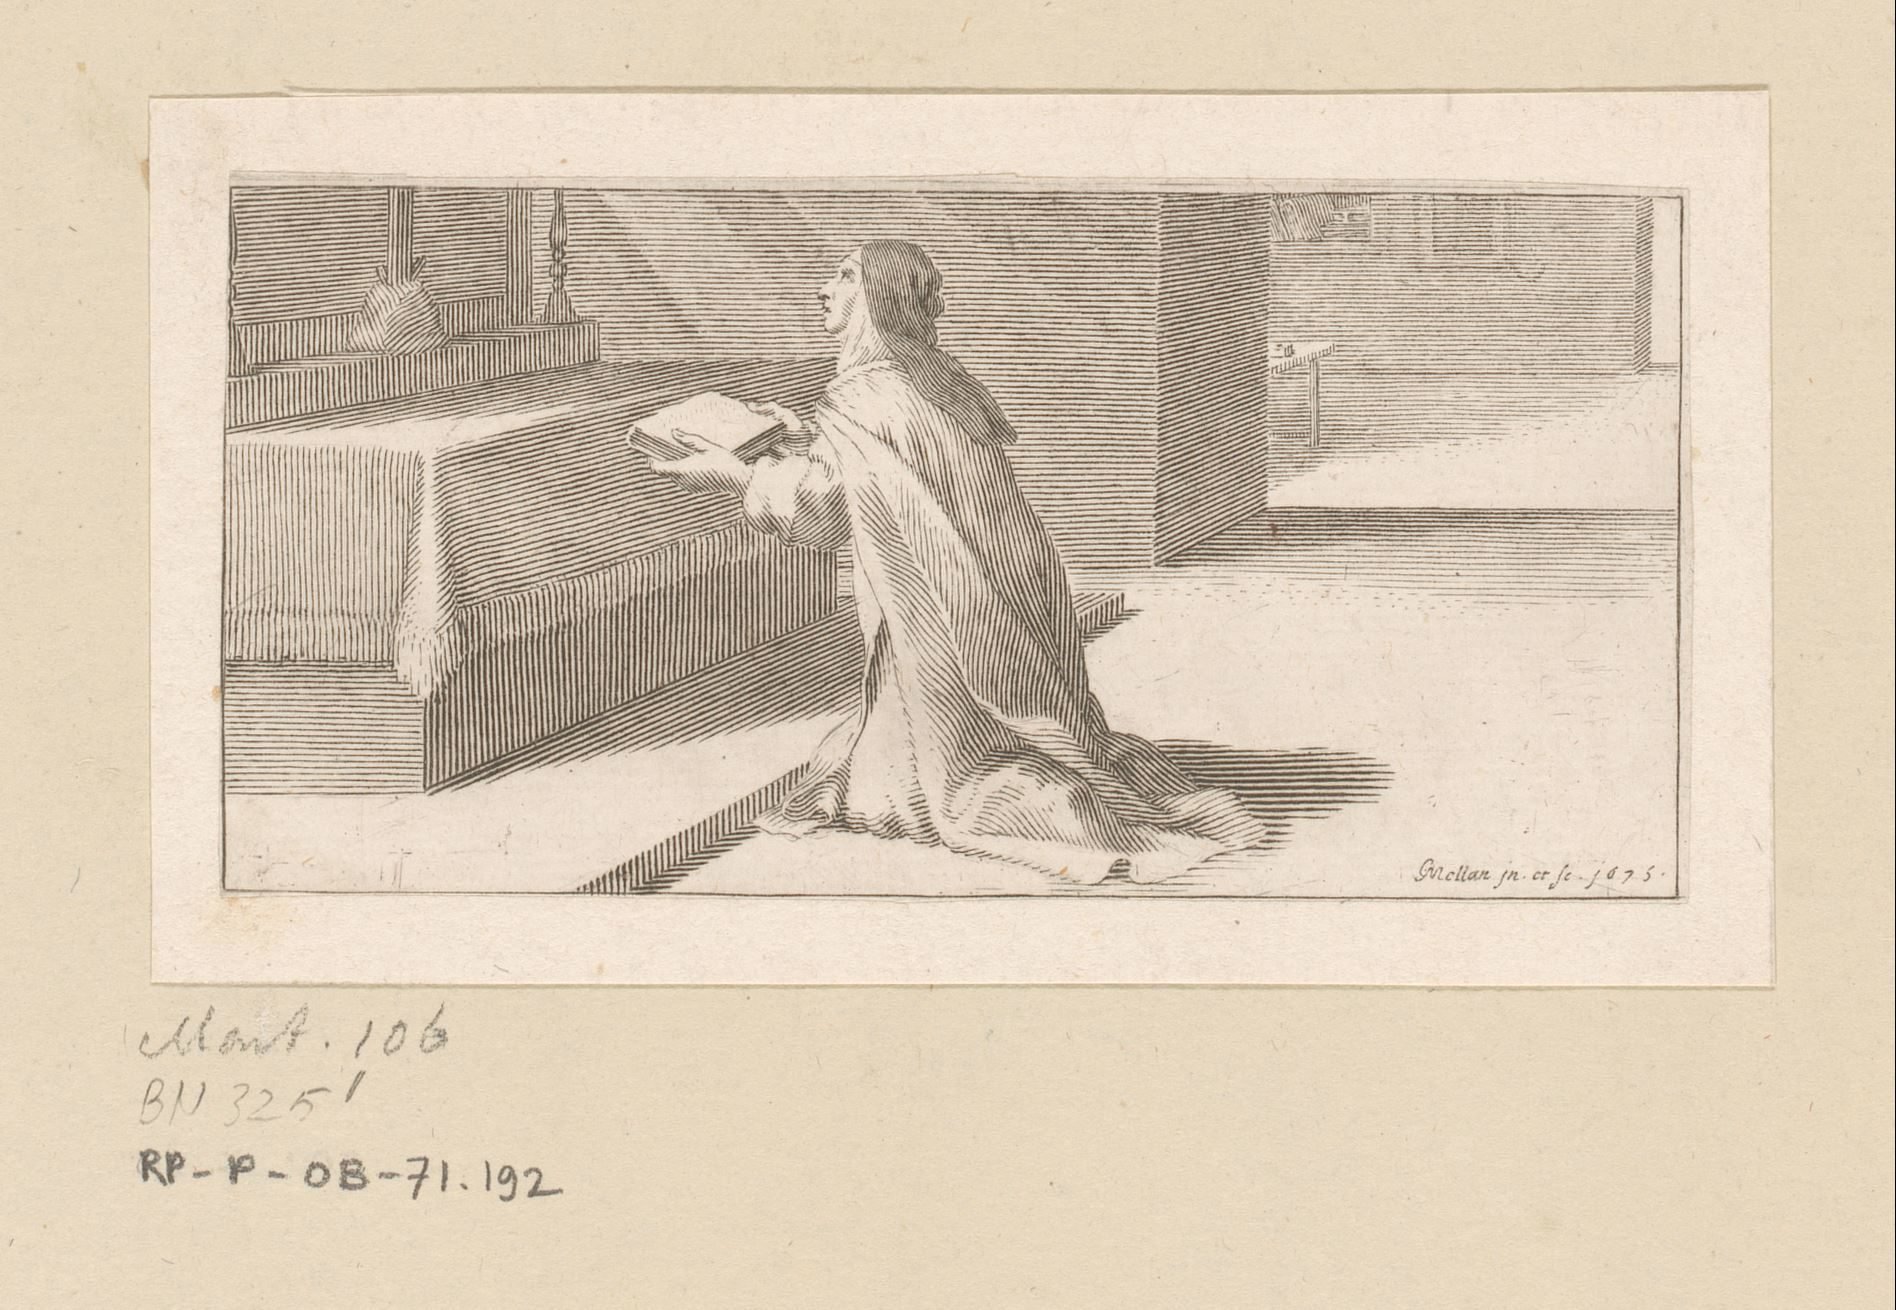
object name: print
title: H. Theresia met een boek voor een altaar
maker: claude mellan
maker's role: draughtsman, print maker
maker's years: 1598-1688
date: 1675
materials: paper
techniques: engraving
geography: france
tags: the foundress of the reformed (discalced) carmelites, t(h)eres(i)a of avila; possible attributes: angel, arrow, dove, heart (flaming or pierced by an arrow)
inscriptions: collector's mark: Lugt 240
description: Tweede staat gebruikt voor: Cureau de la Chambre, Pierre. Panégyrique de sainte Thérèse prononcé devant la reine en l'église des Carmélites de la rue du Boulloy. Parijs: Jean-Baptiste Coignard, 1678.